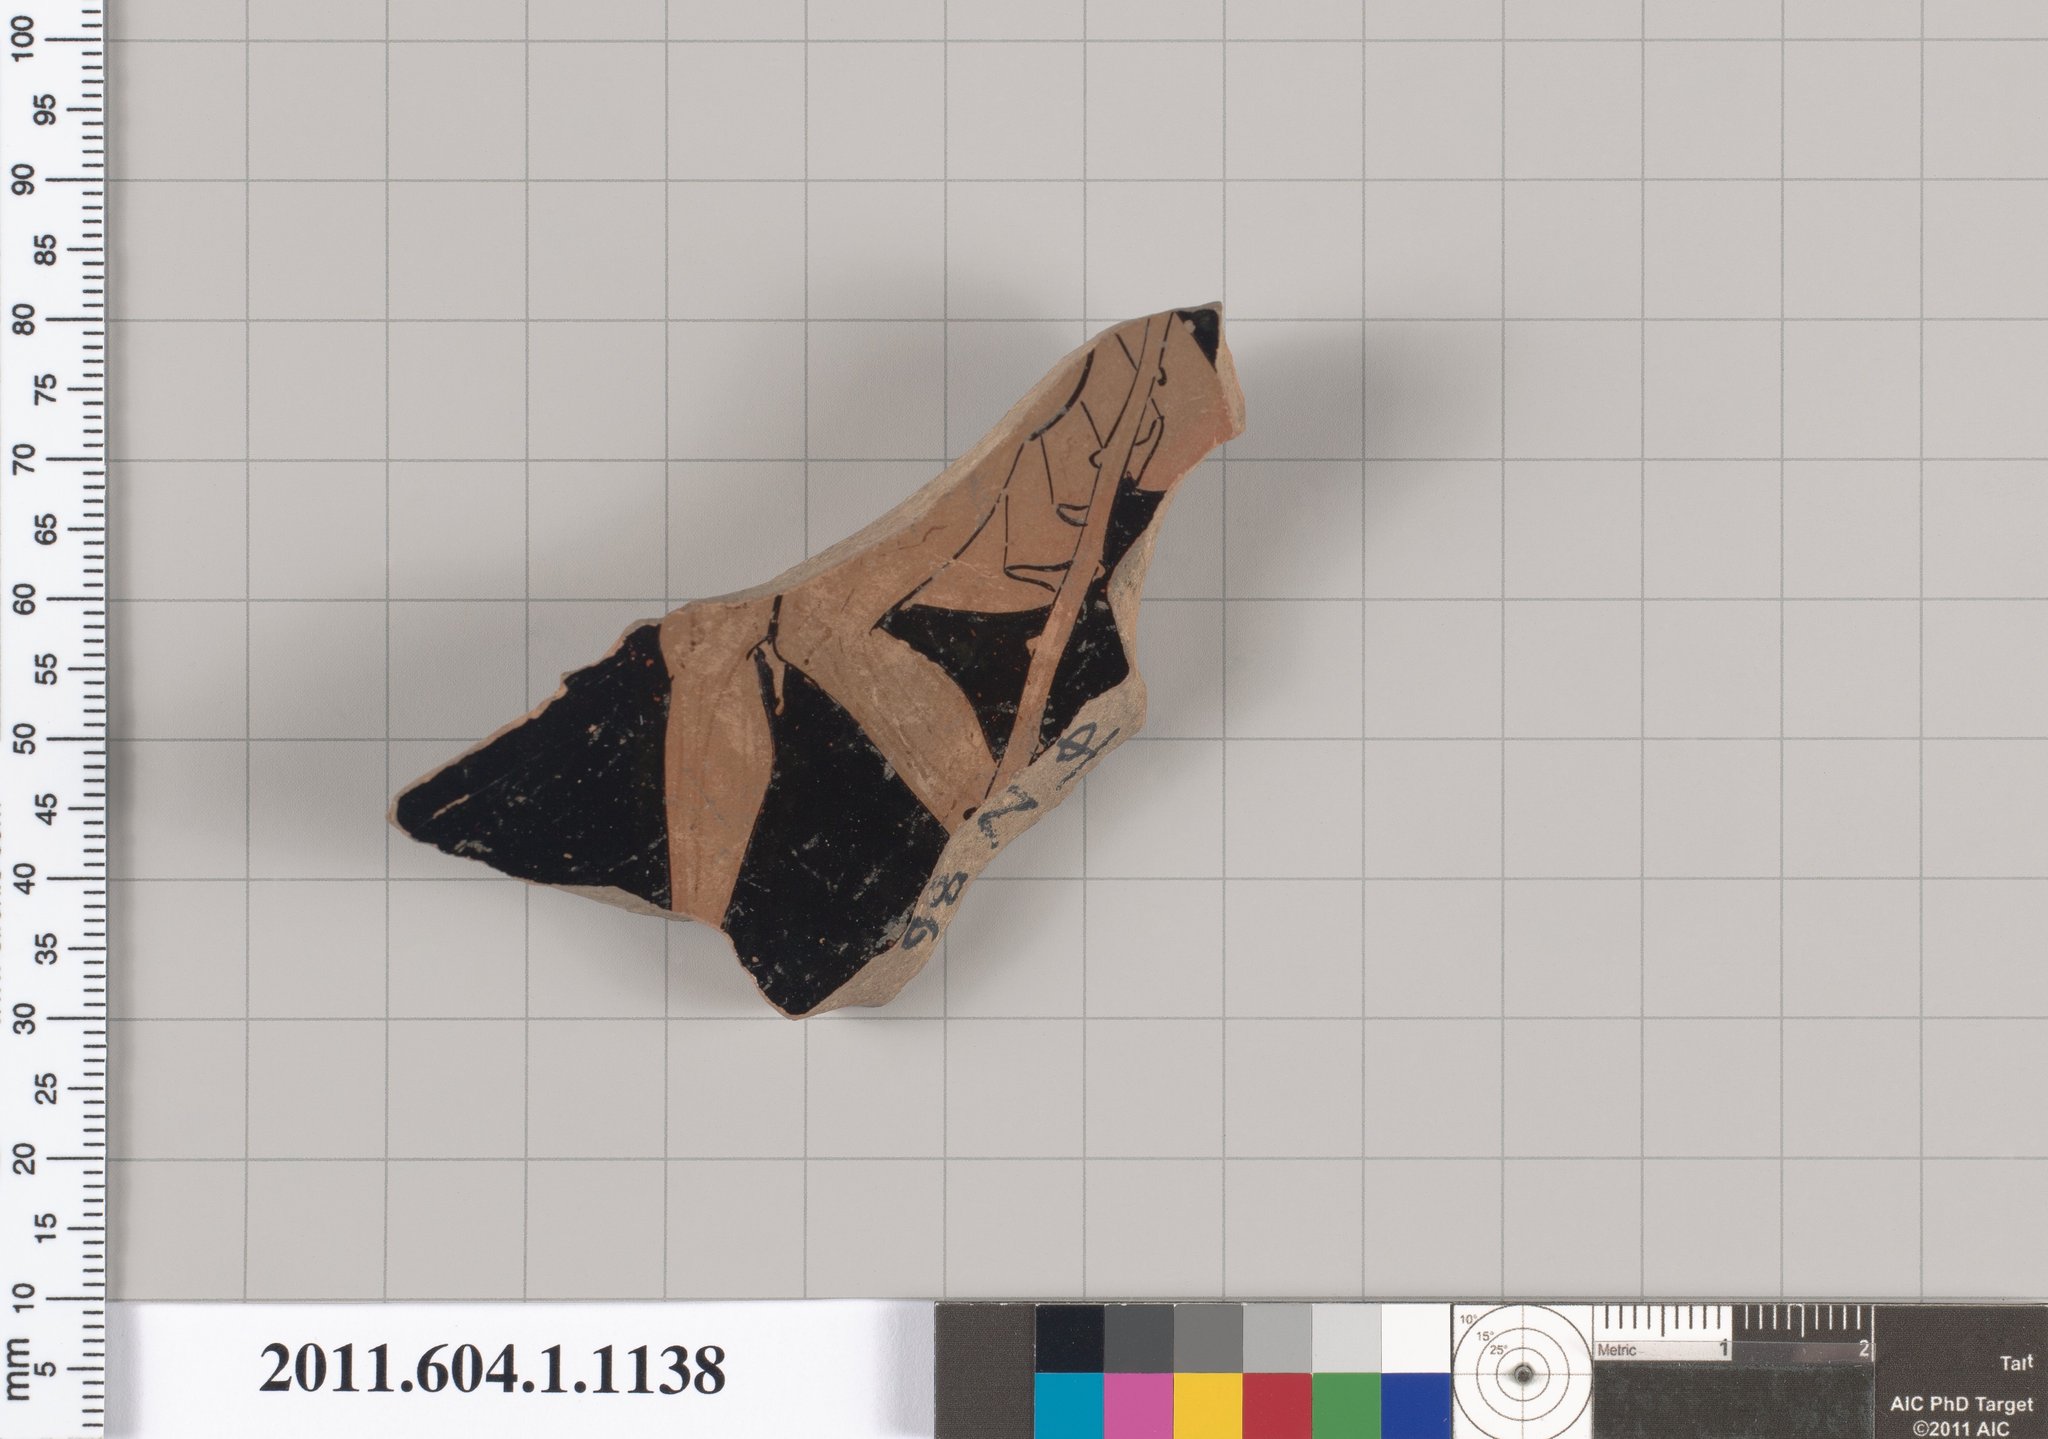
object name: kylix fragment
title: Terracotta fragment of a kylix (drinking cup)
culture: greek, attic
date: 490-480 BCE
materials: terracotta